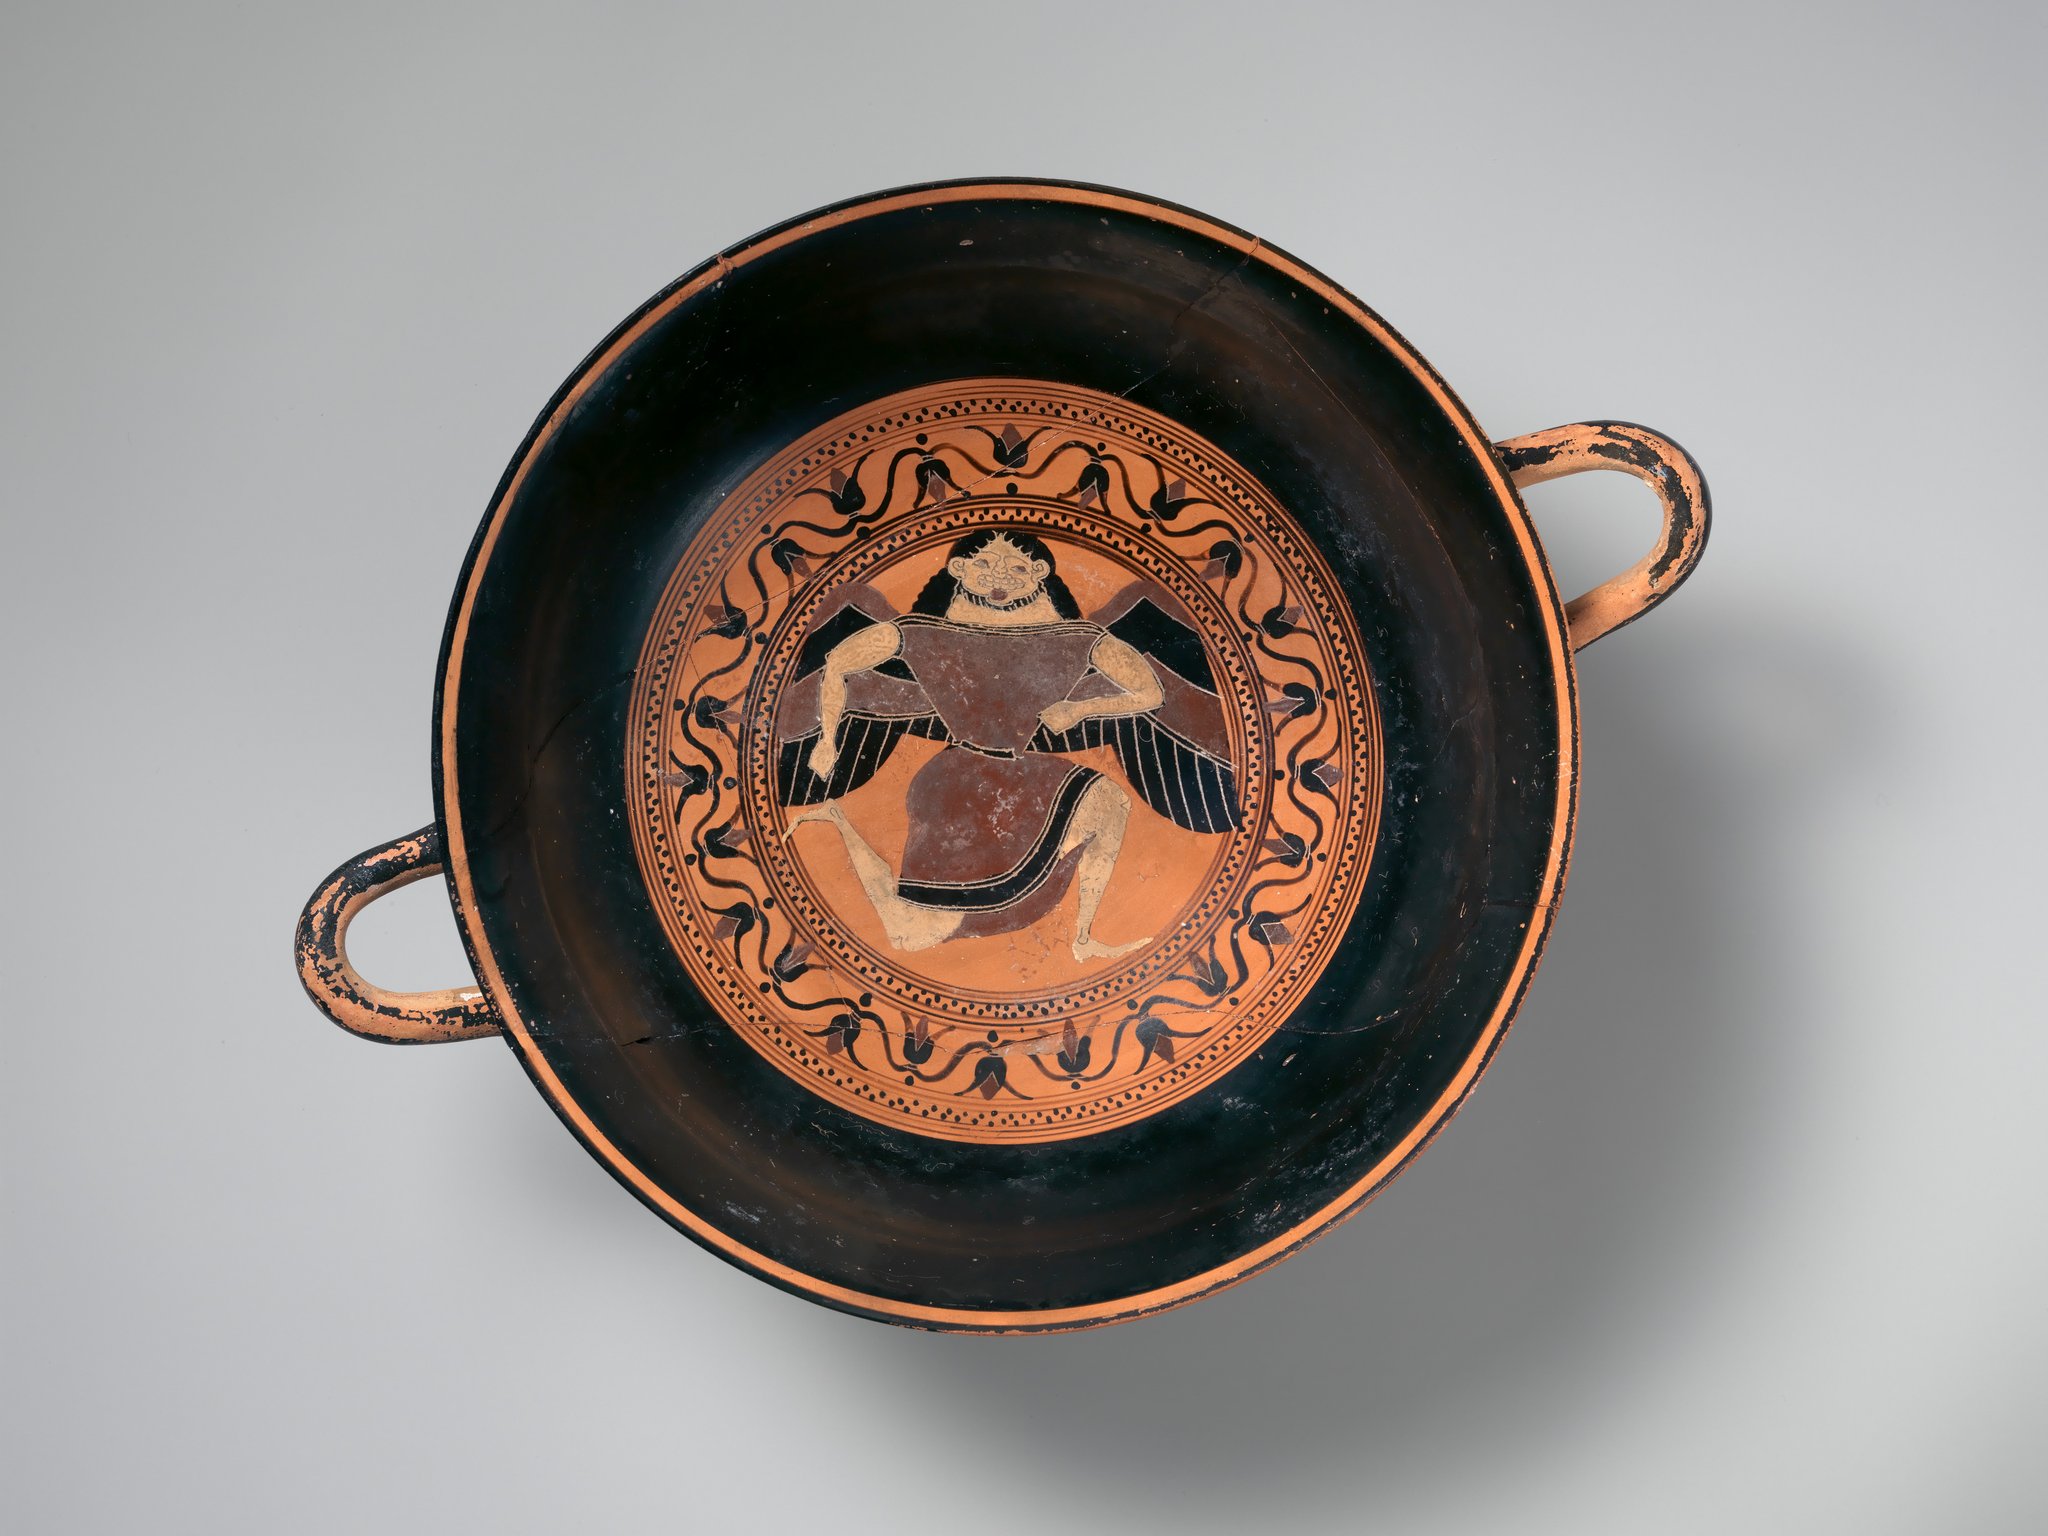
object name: kylix, siana cup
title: Terracotta kylix: Siana cup (drinking cup)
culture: greek, attic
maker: c painter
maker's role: artist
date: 575 BCE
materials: terracotta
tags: shields,men,achilles,horses